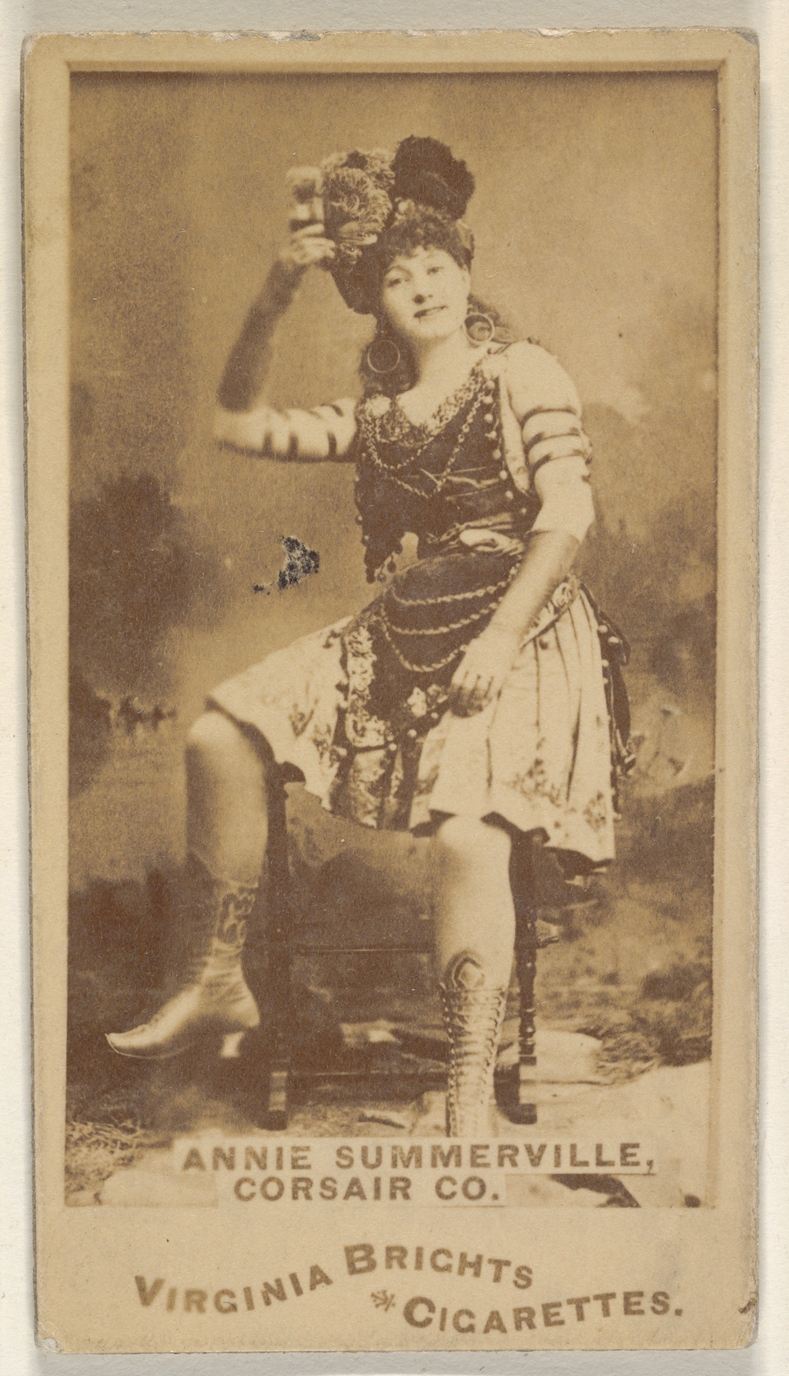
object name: photograph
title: Annie Summerville, Corsair Co., from the Actors and Actresses series (N45, Type 1) for Virginia Brights Cigarettes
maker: allen & ginter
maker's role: publisher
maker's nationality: american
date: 1888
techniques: albumen silver print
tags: portraits,women,actresses